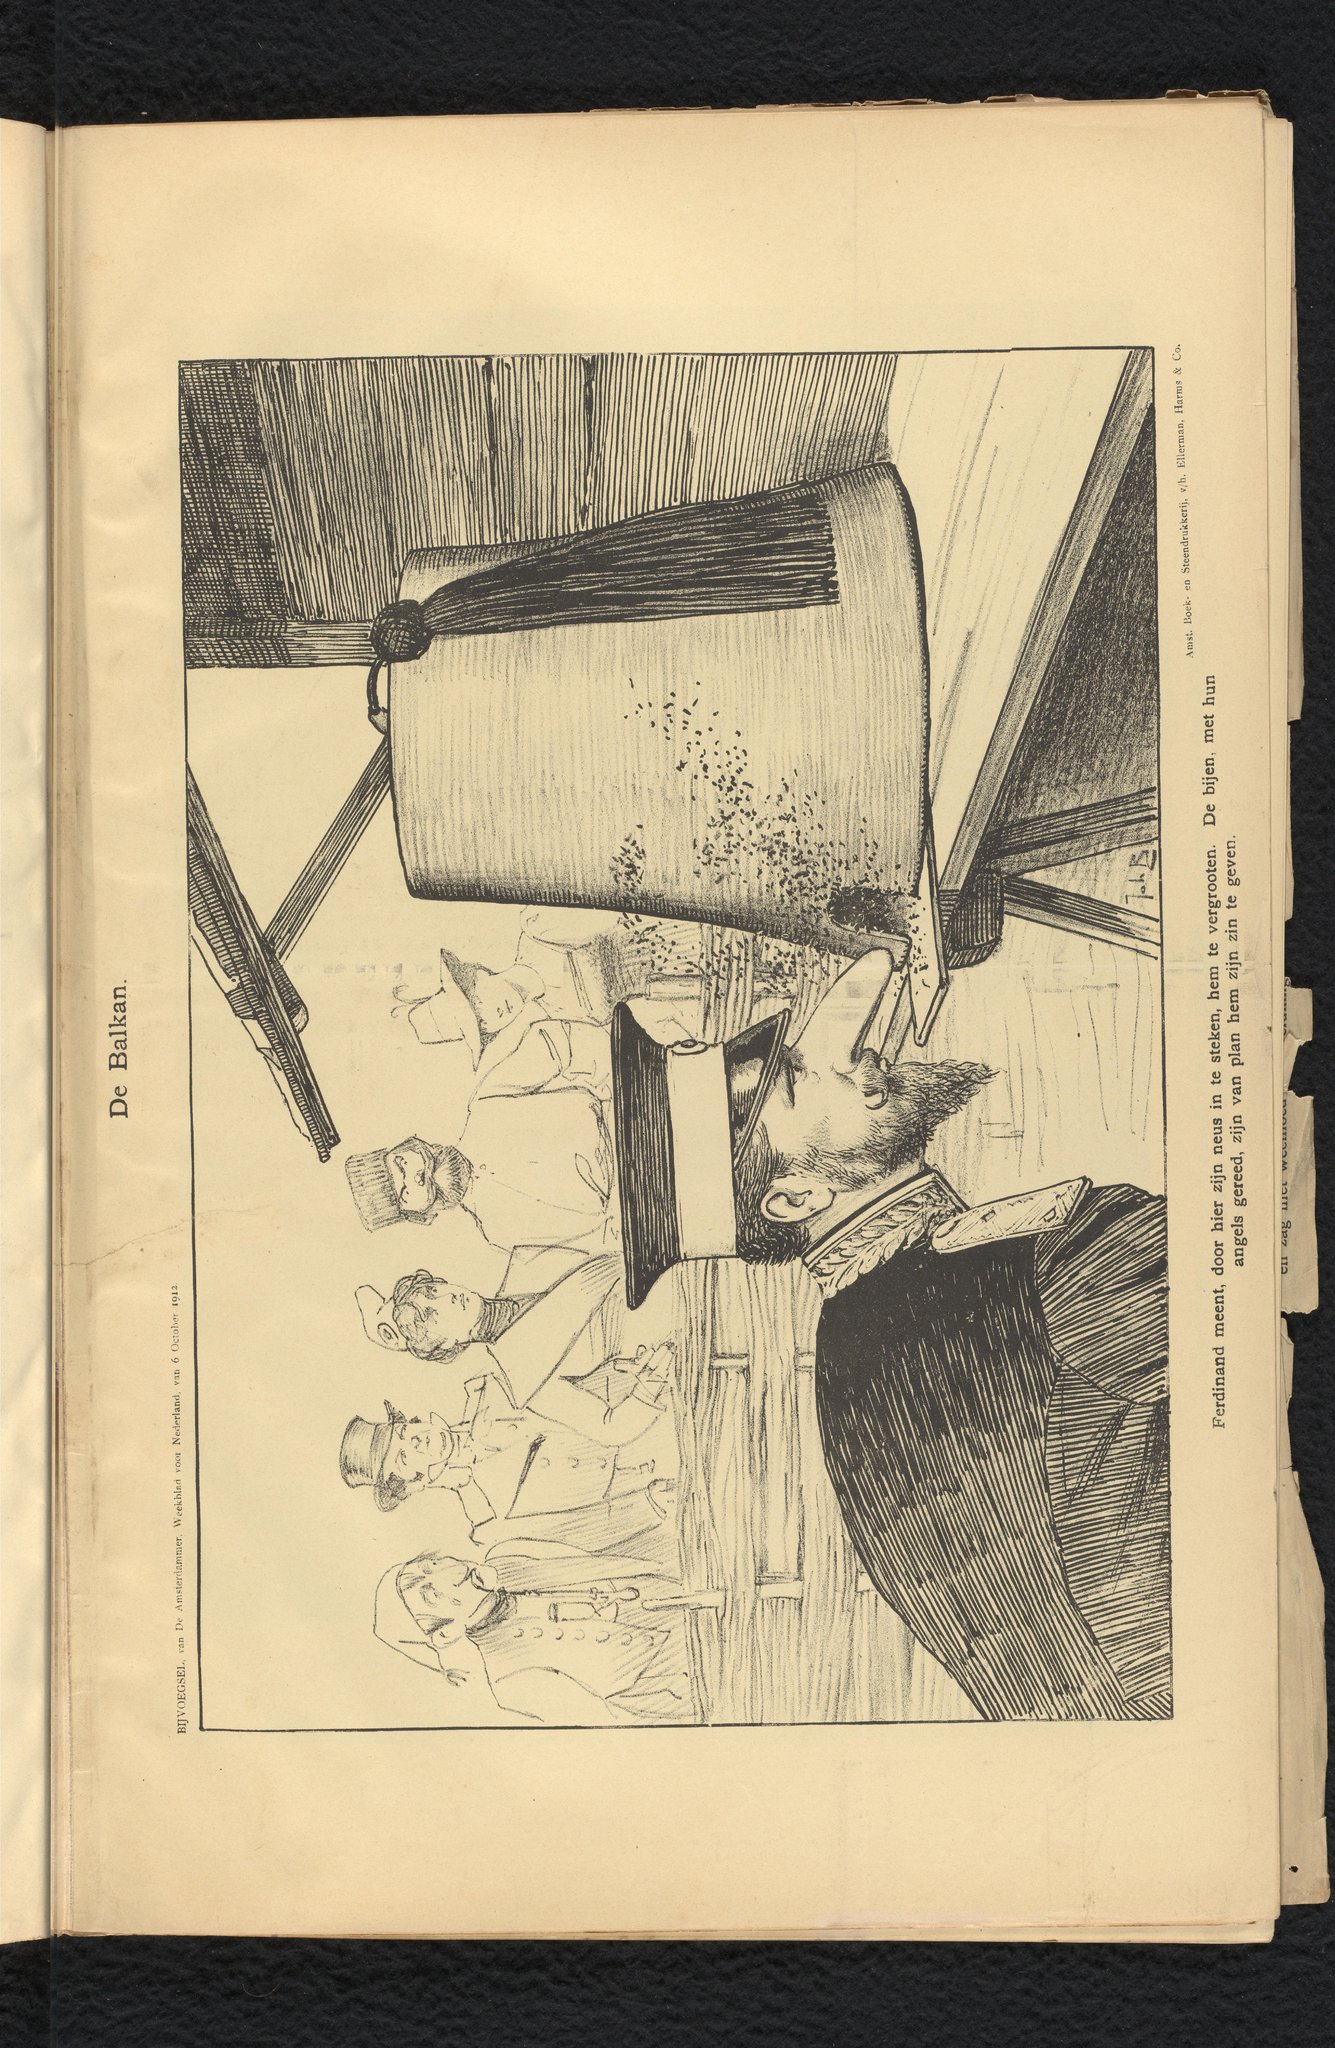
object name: cartoon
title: De Balkan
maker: johan braakensiek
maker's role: draughtsman, print maker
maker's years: 1858-1940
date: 1912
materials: paper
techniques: lithograph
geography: amsterdam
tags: vienna, personifications of countries, nations, states, districts, etc., bee-hive, parts of the face: nose, political caricatures and satires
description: Ferdinand I van Bulgarije steekt zijn lange neus in een bijenkorf, het conflict in de Balkan. De andere Europese mogendheden zien van een afstand toe.